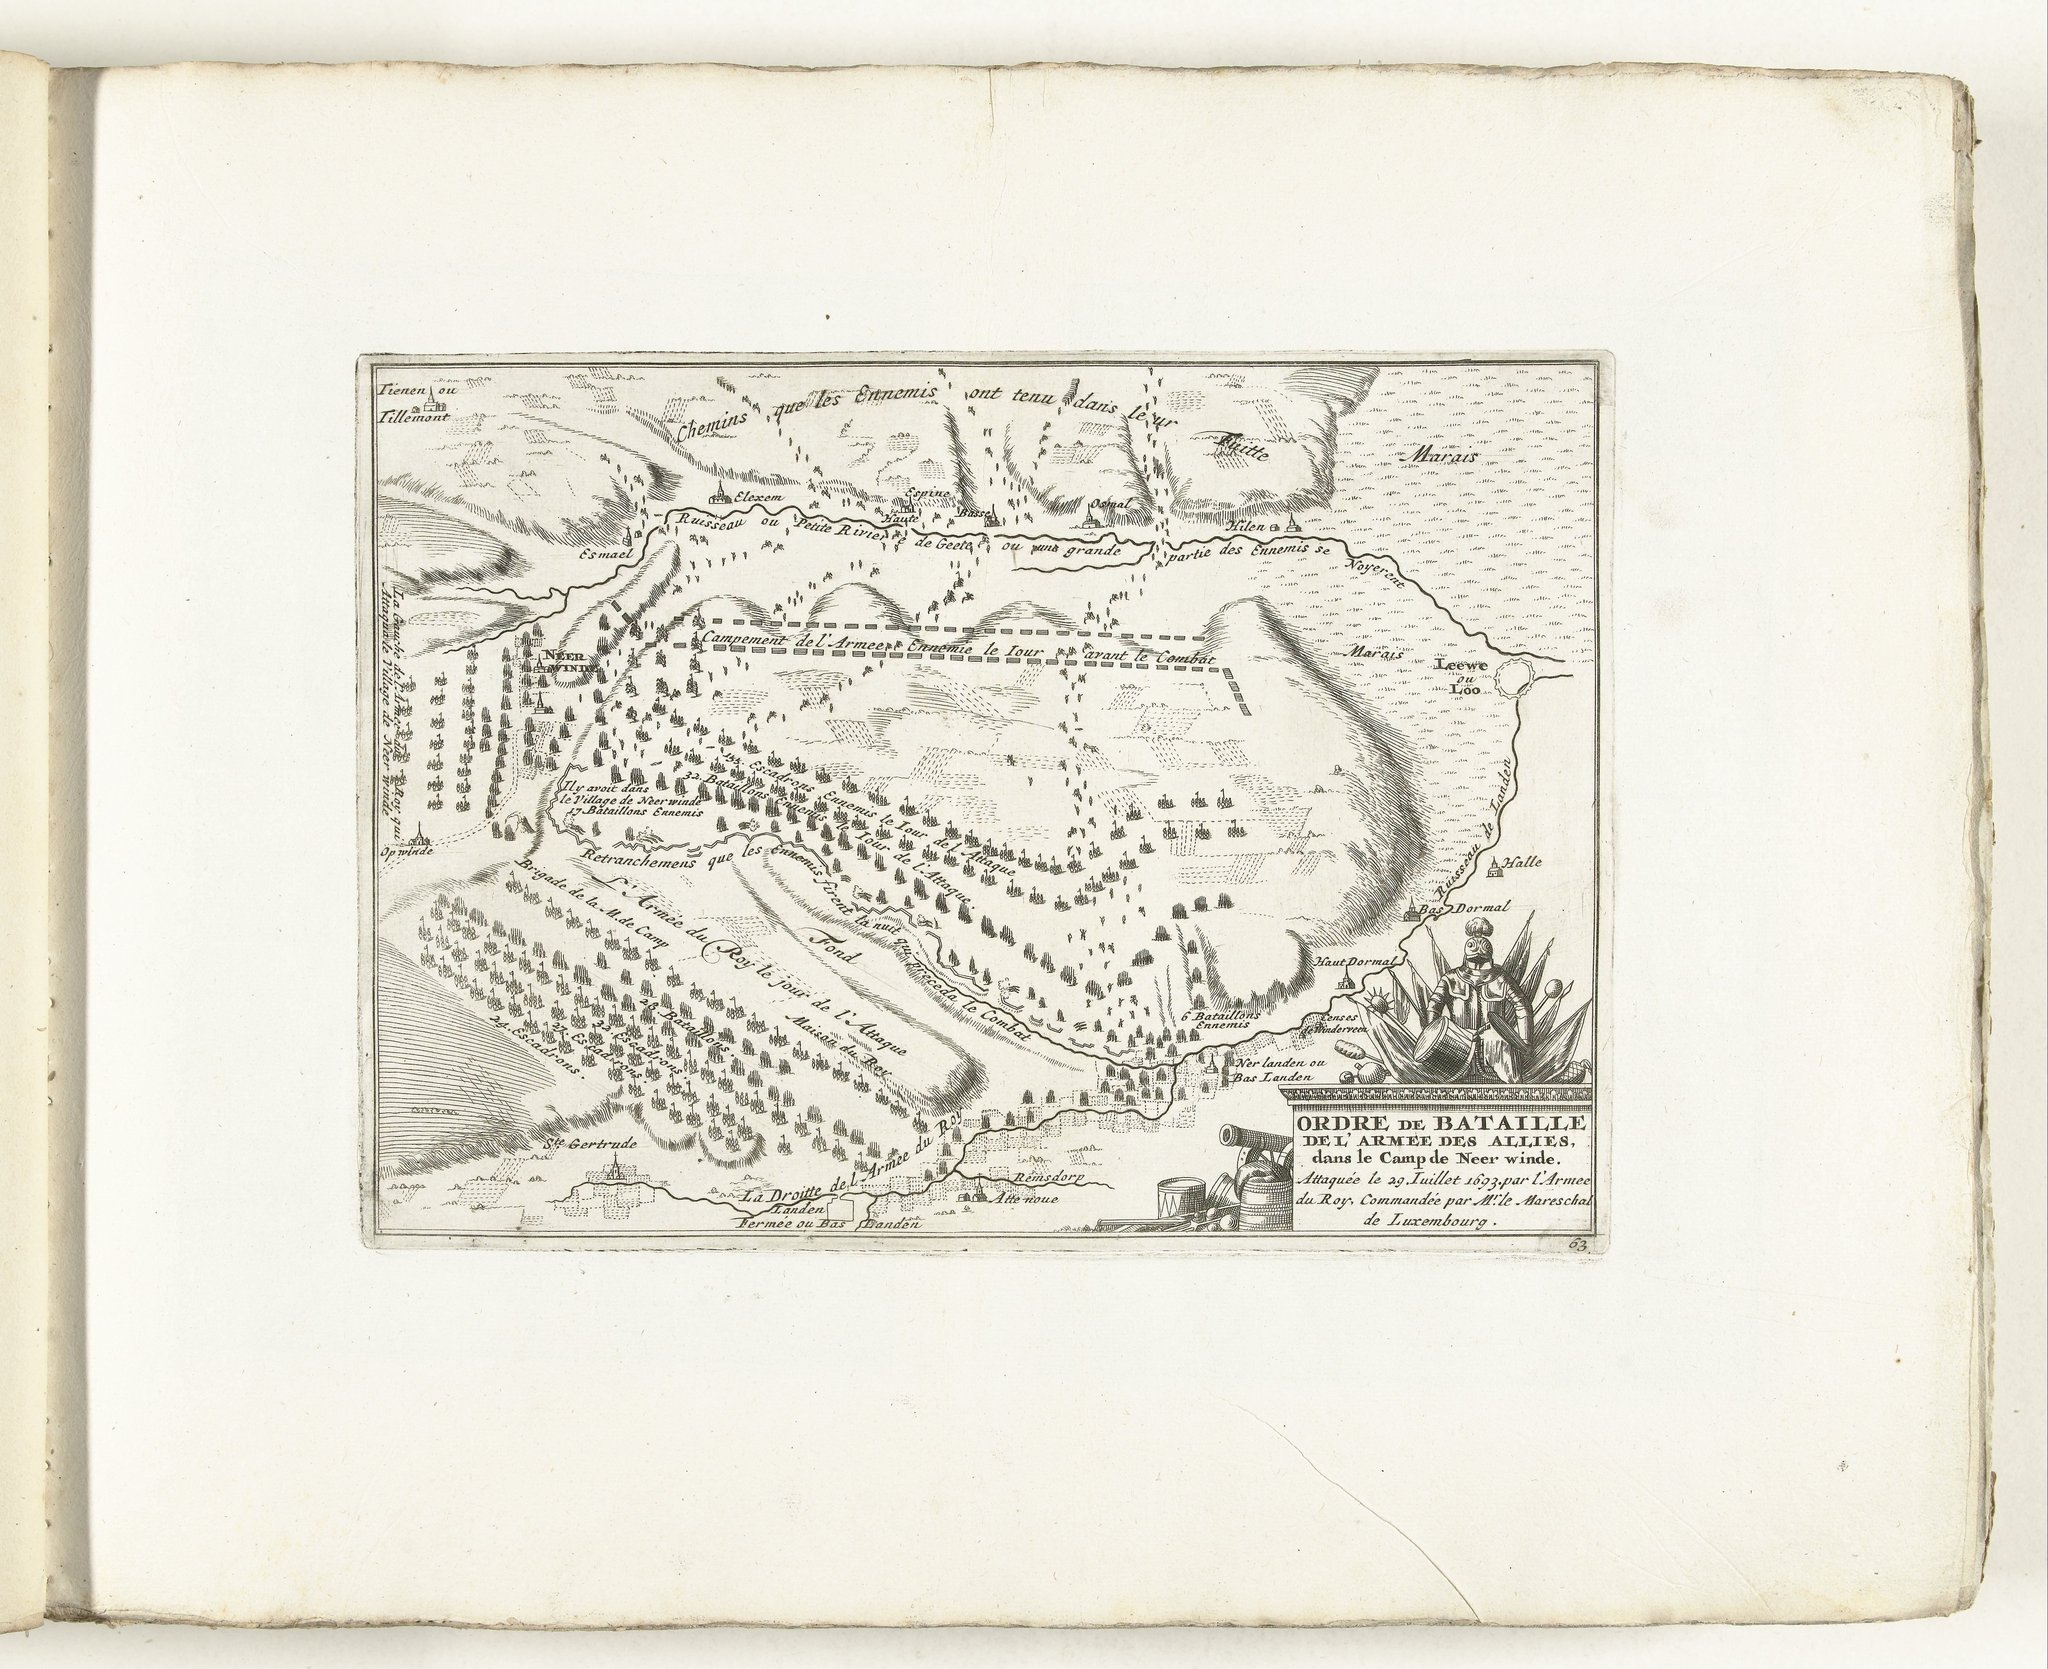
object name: map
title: Slag bij Landen, 1693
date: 1702-1703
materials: paper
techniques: etching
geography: amsterdam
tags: maps of separate countries or regions, battle (+ land forces)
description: Plan van de slag bij Landen, ook bekend als de slag bij Neerwinden, waar de geallieerden door het Franse leger verslagen worden, 29 juli 1693. Plaat nr. 63 in het prentwerk bestaande in totaal uit 276 genummerde platen van vermaarde sterke steden en vestingen in het kader van de Spaanse Successieoorlog. Voor het merendeel zijn deze platen gekopieerd naar de anonieme Franse platen: in Les forces de l'Europe en in: Le theatre de la guerre, dans les Pays-Bas, beide oorspronkelijk uitgegeven door Nicolas de Fer te Parijs (1693-1697) in het kader van de Negenjarige Oorlog. Titel en opschriften in de plaat in het Frans.